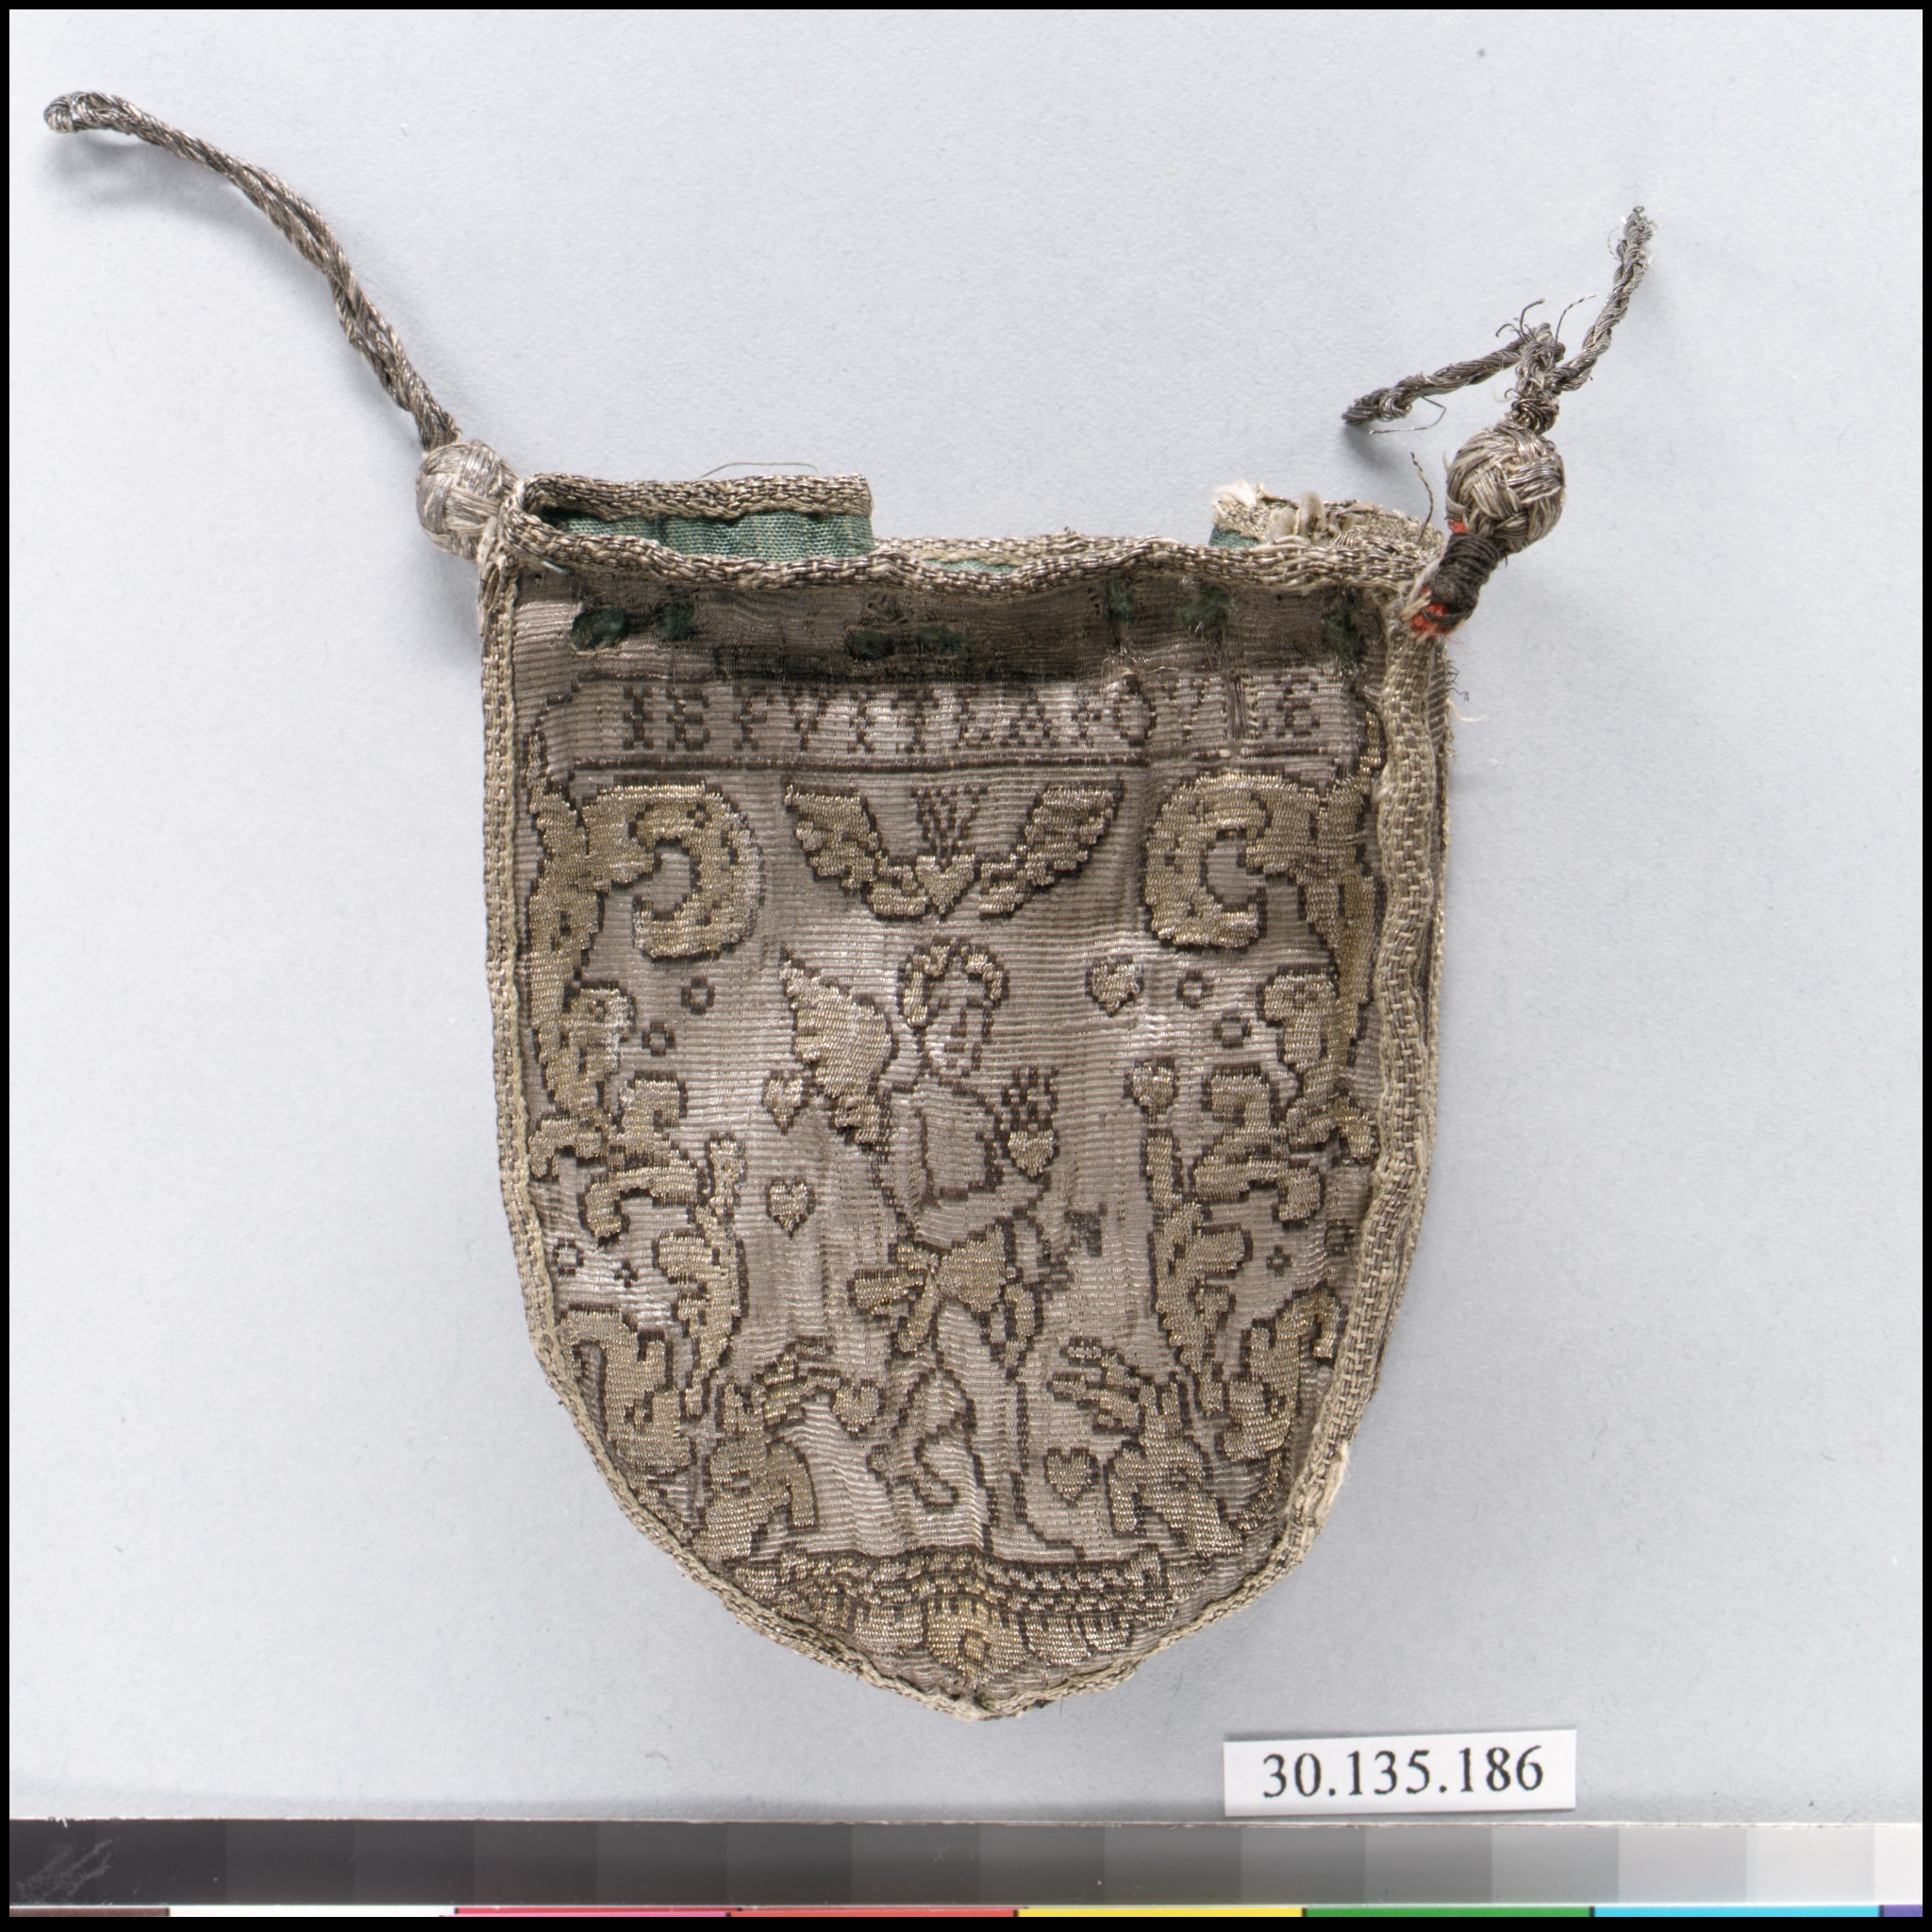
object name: bag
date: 1601-1700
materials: metal thread, silk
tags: putti